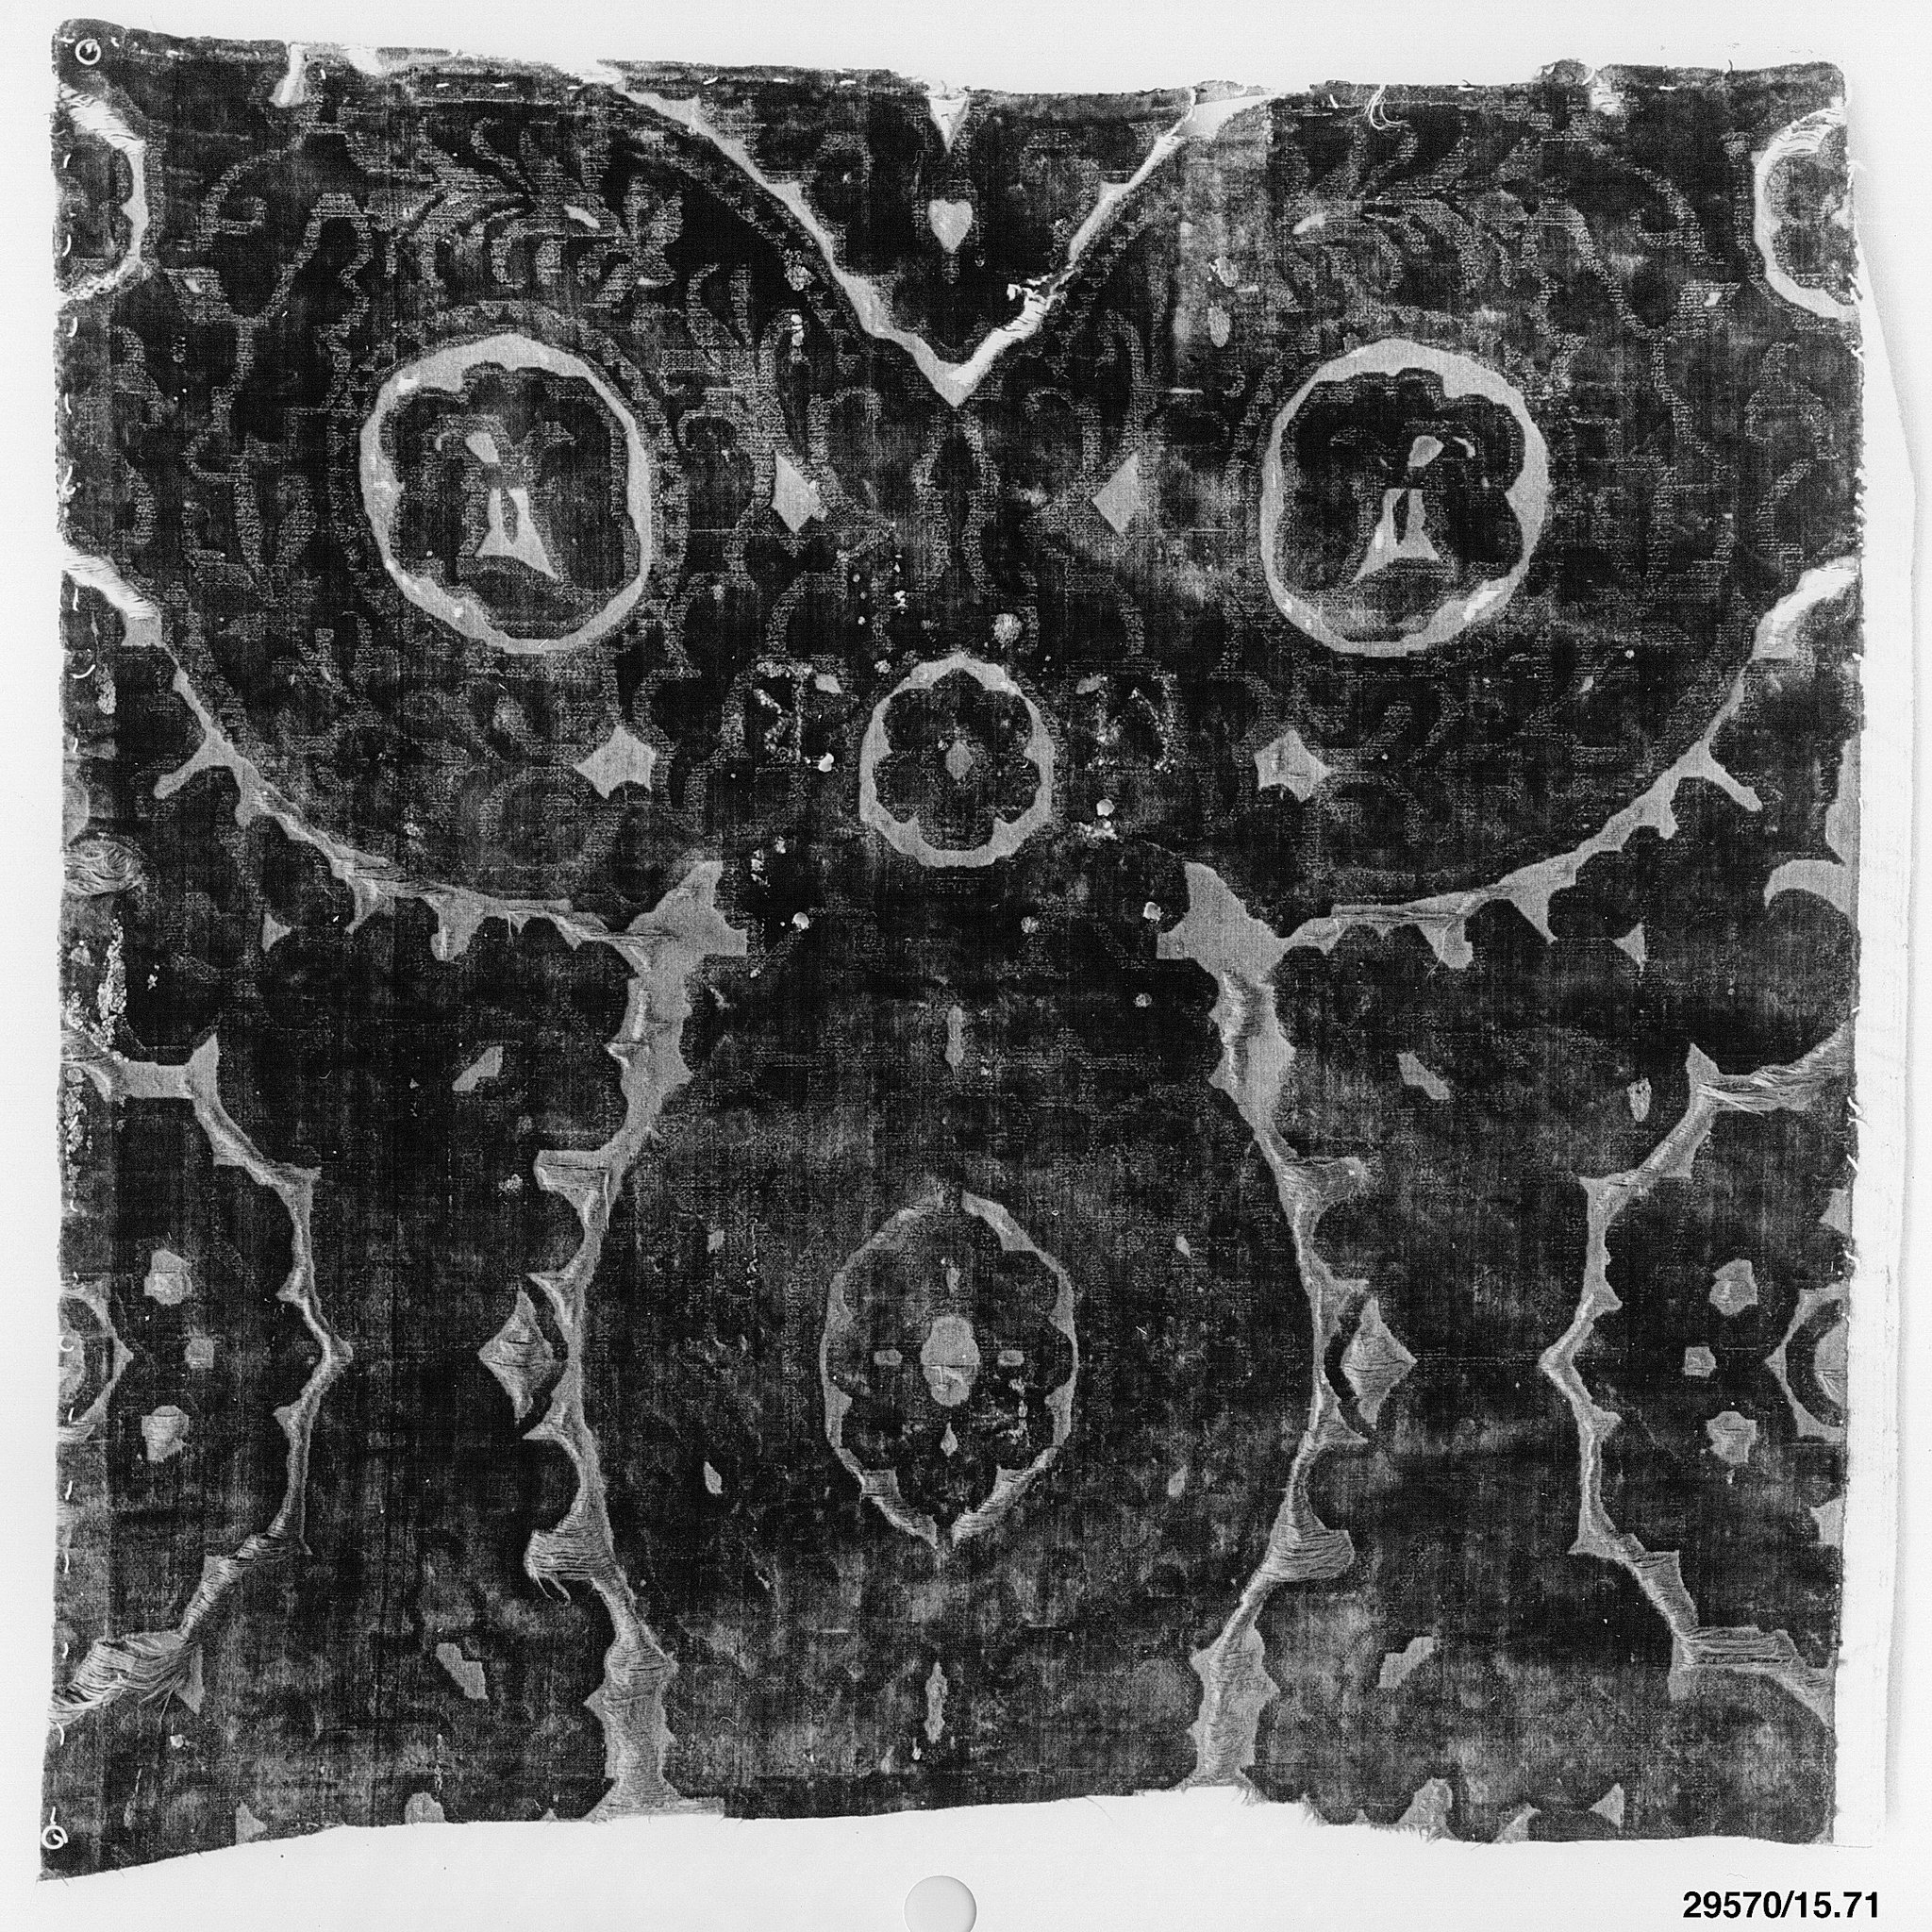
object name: piece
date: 1501-1700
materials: silk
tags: flowers,leaves